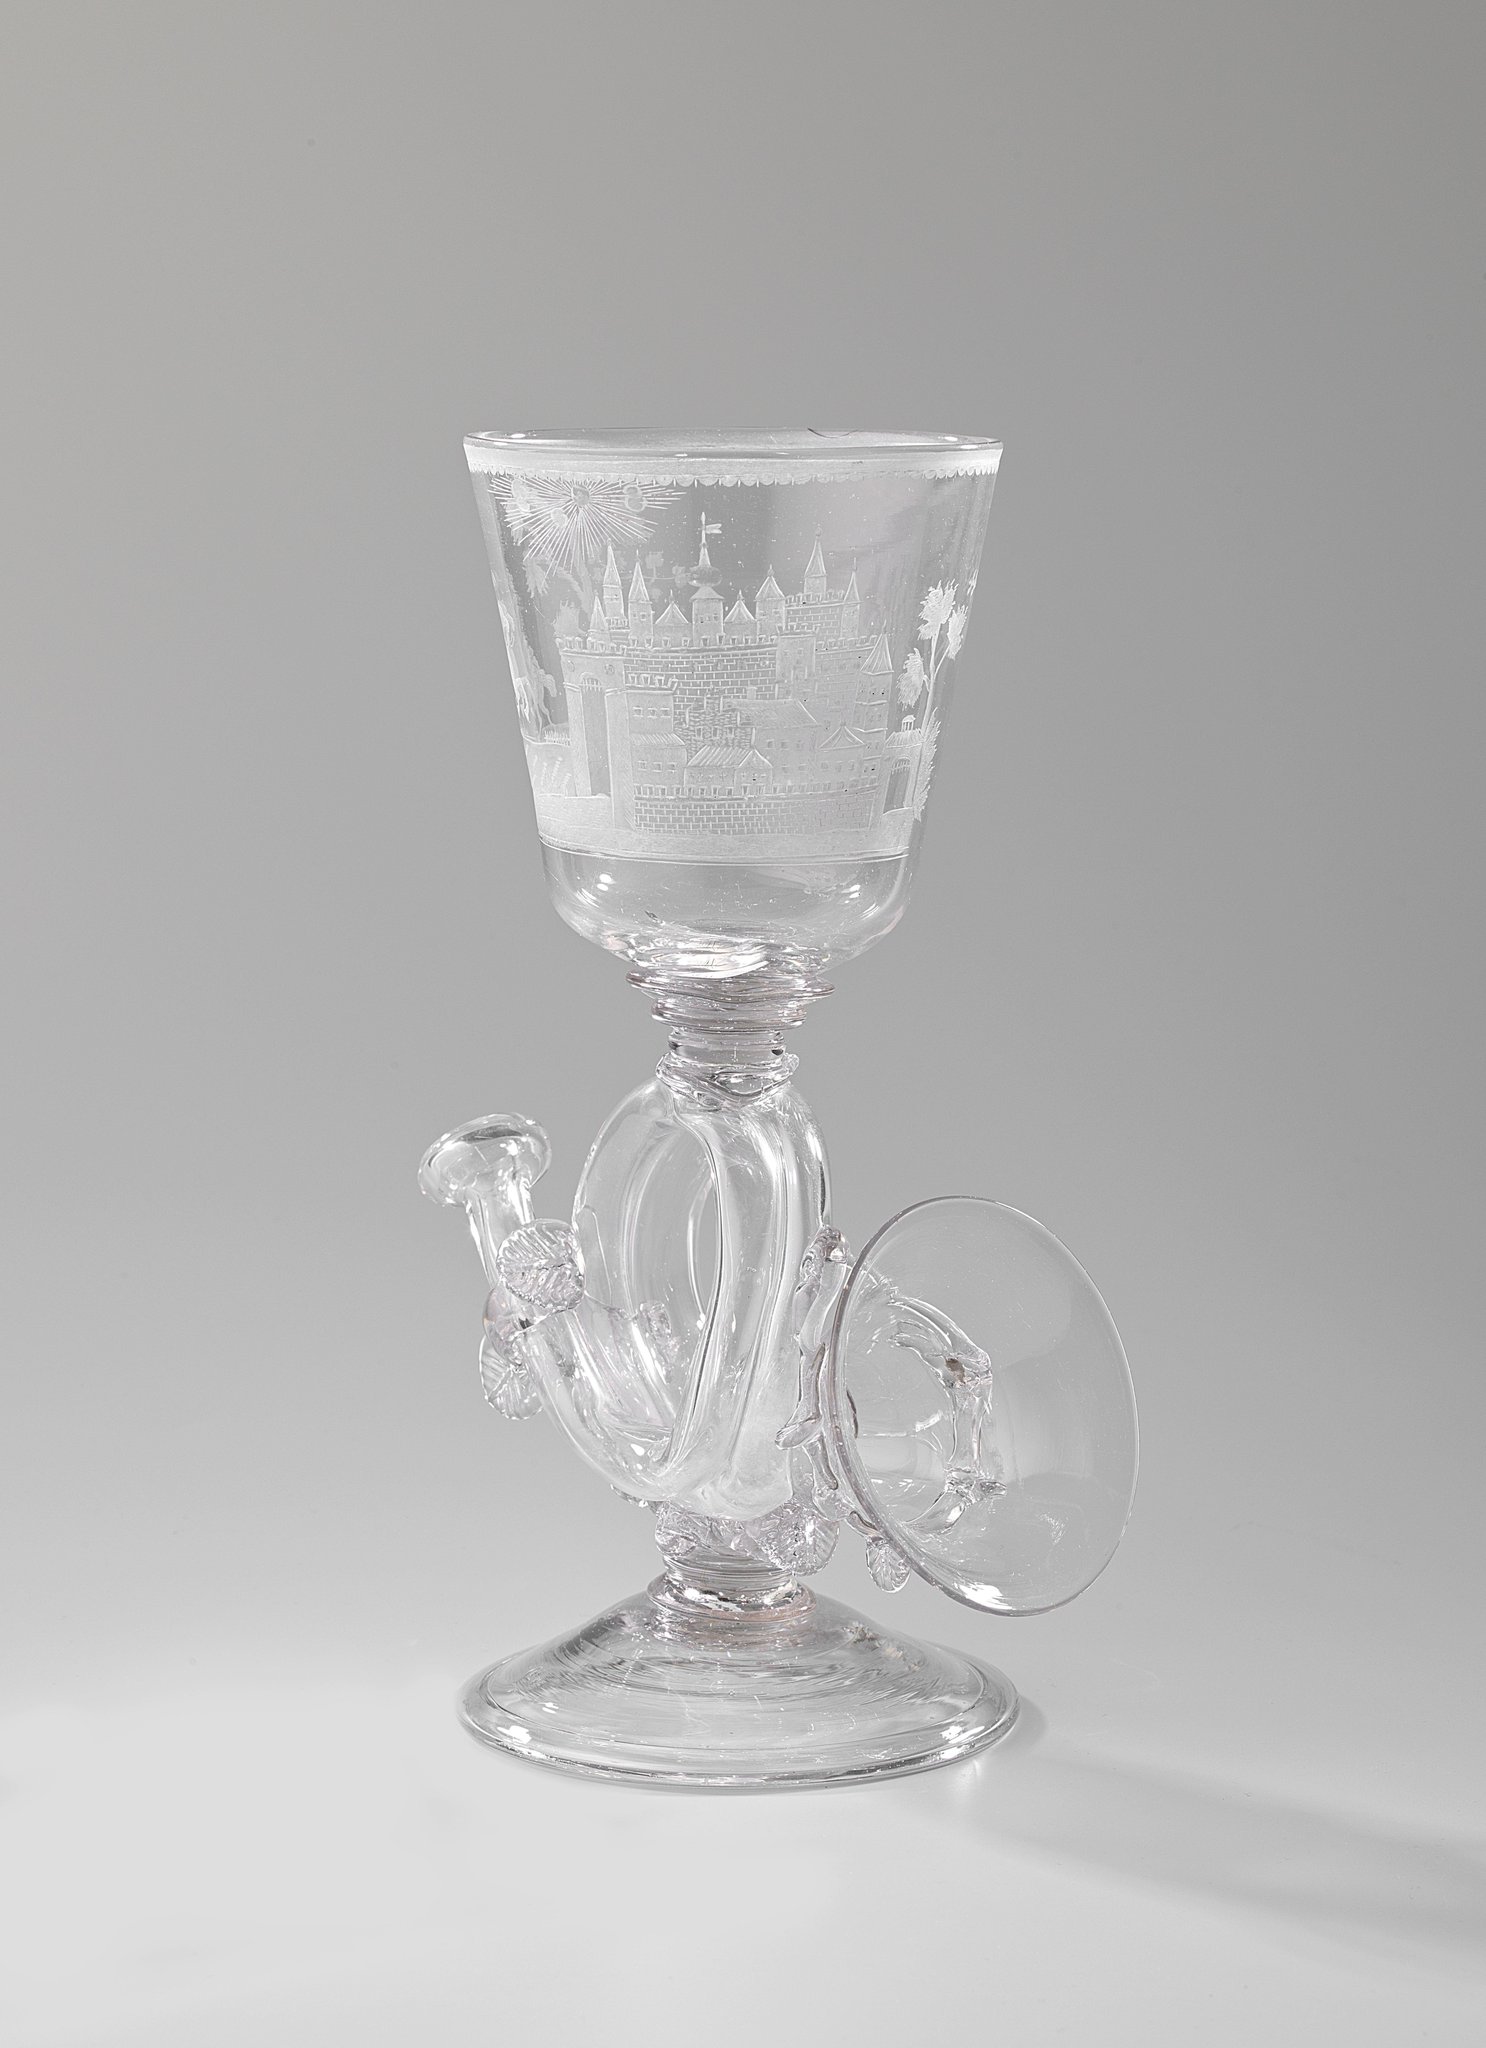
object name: trick glass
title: Wine glass in the shape of a post horn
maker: Anonymous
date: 1725-1775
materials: glass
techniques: glassblowing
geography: bohemia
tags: messenger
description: Bokaal. Radgravure met een ommuurde stad en een ruiter met een posthoorn. Bohemen, ca. 1700 - 1800.